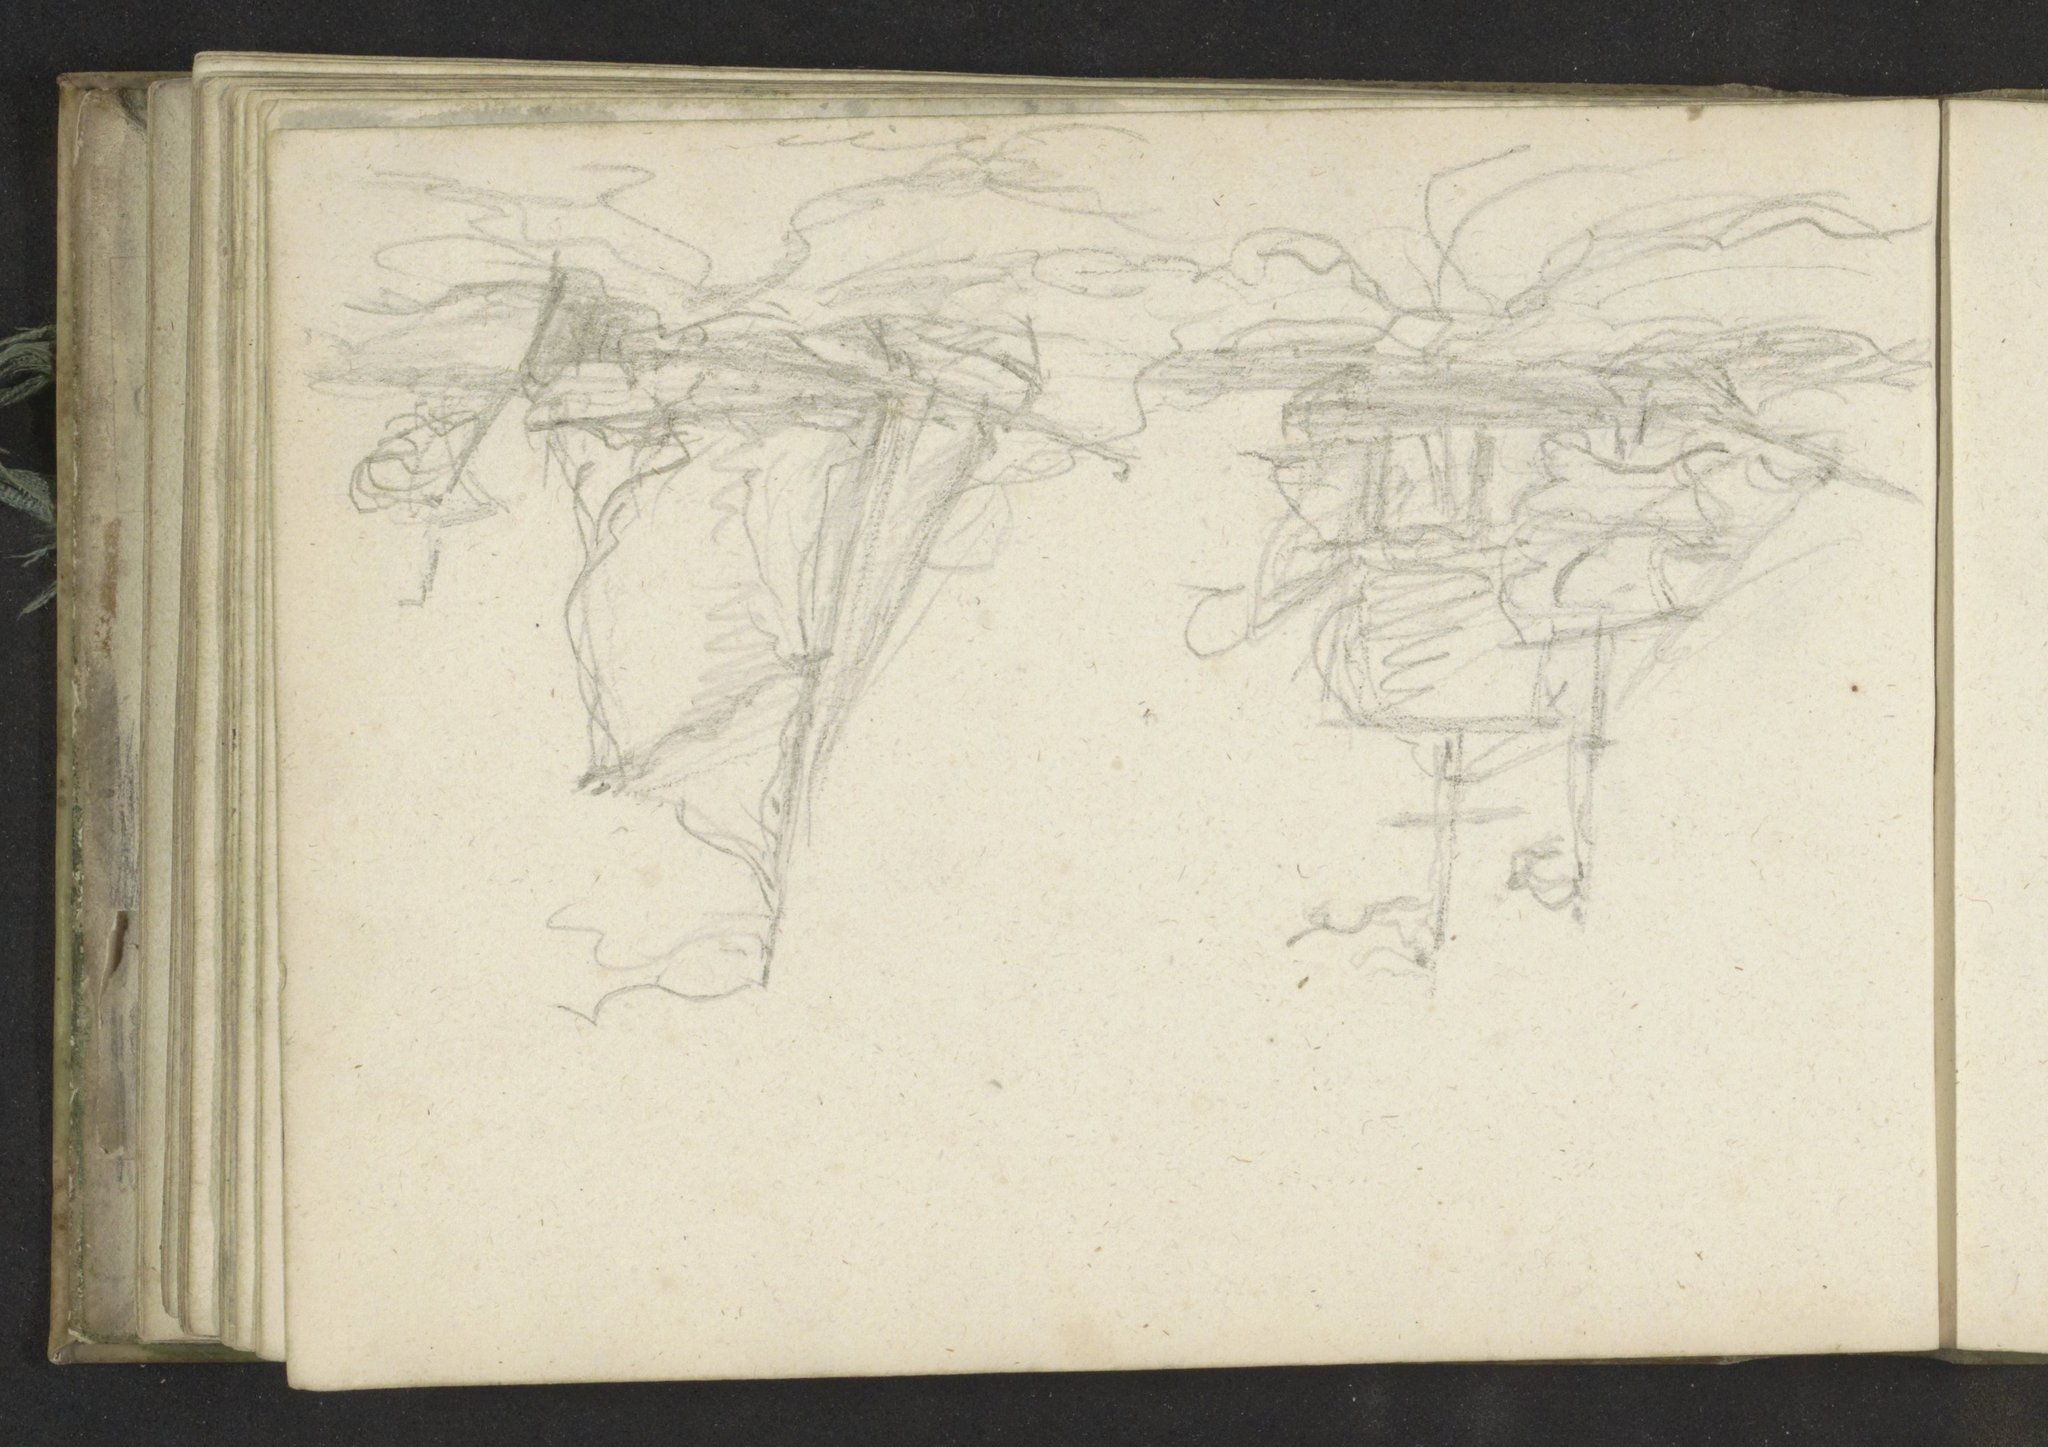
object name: sketchbook leaf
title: Drie zeilschepen op het water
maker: martinus schouman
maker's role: draughtsman, painter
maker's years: 1770-1848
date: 1780-1848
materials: chalk, paper, pencil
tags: sailing-ship, sailing-boat, landscapes with waters, waterscapes, seascapes (in the temperate zone)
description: Blad 44 verso uit een schetsboek met 53 bladen.